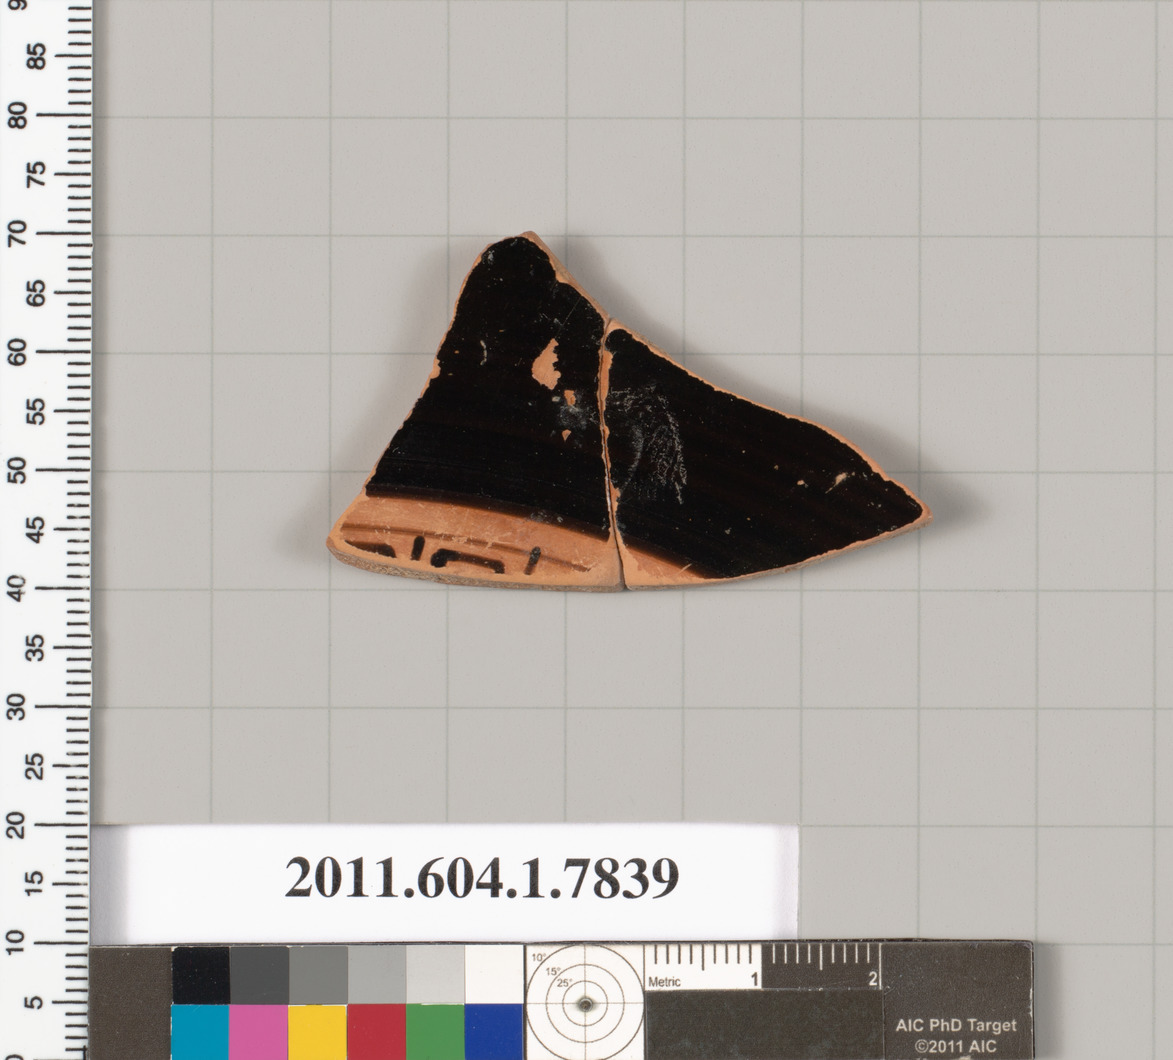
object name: kylix fragment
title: Terracotta fragment of a kylix (drinking cup)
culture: greek, attic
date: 470-450 BCE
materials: terracotta